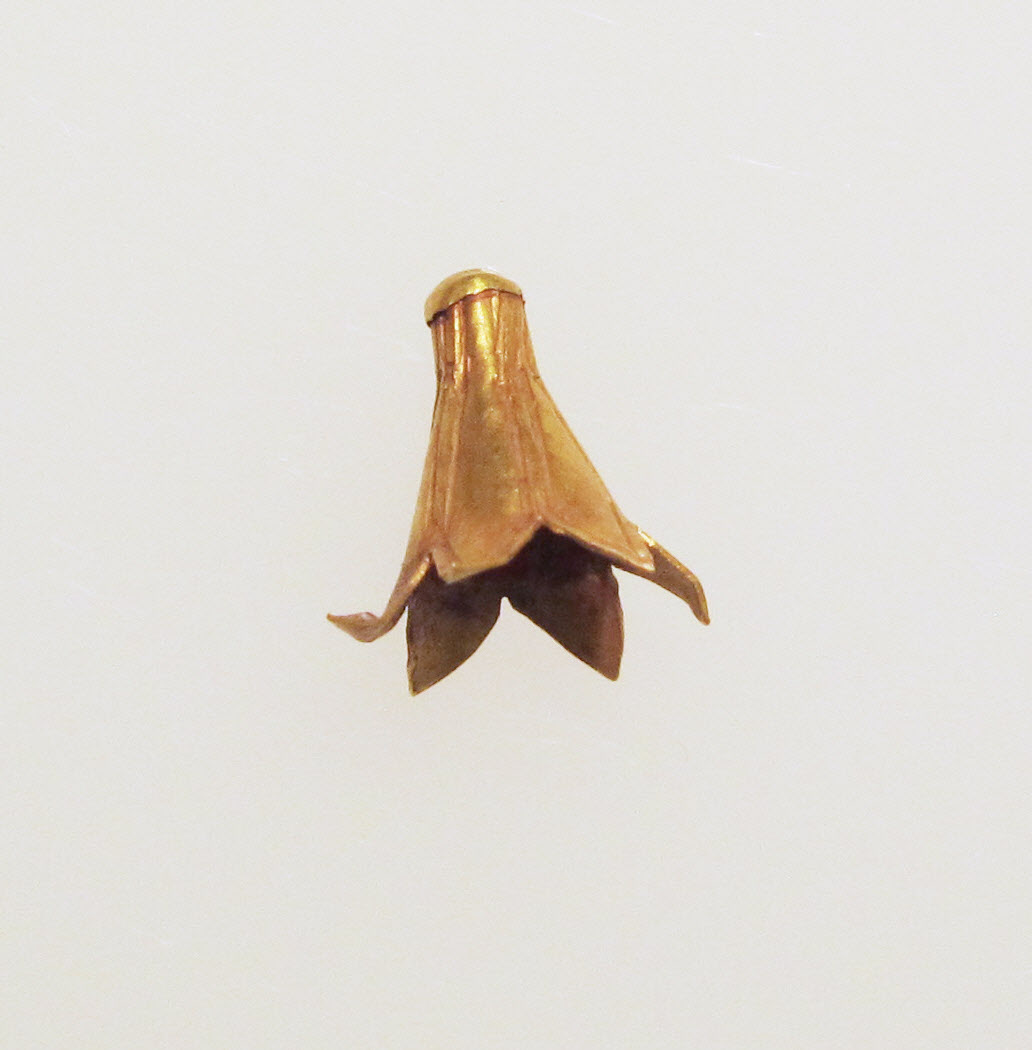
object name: ornament, flower shaped mount for stone bead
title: Ornament, flower-shaped mount for stone bead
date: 7000 BCE-330 CE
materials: gold